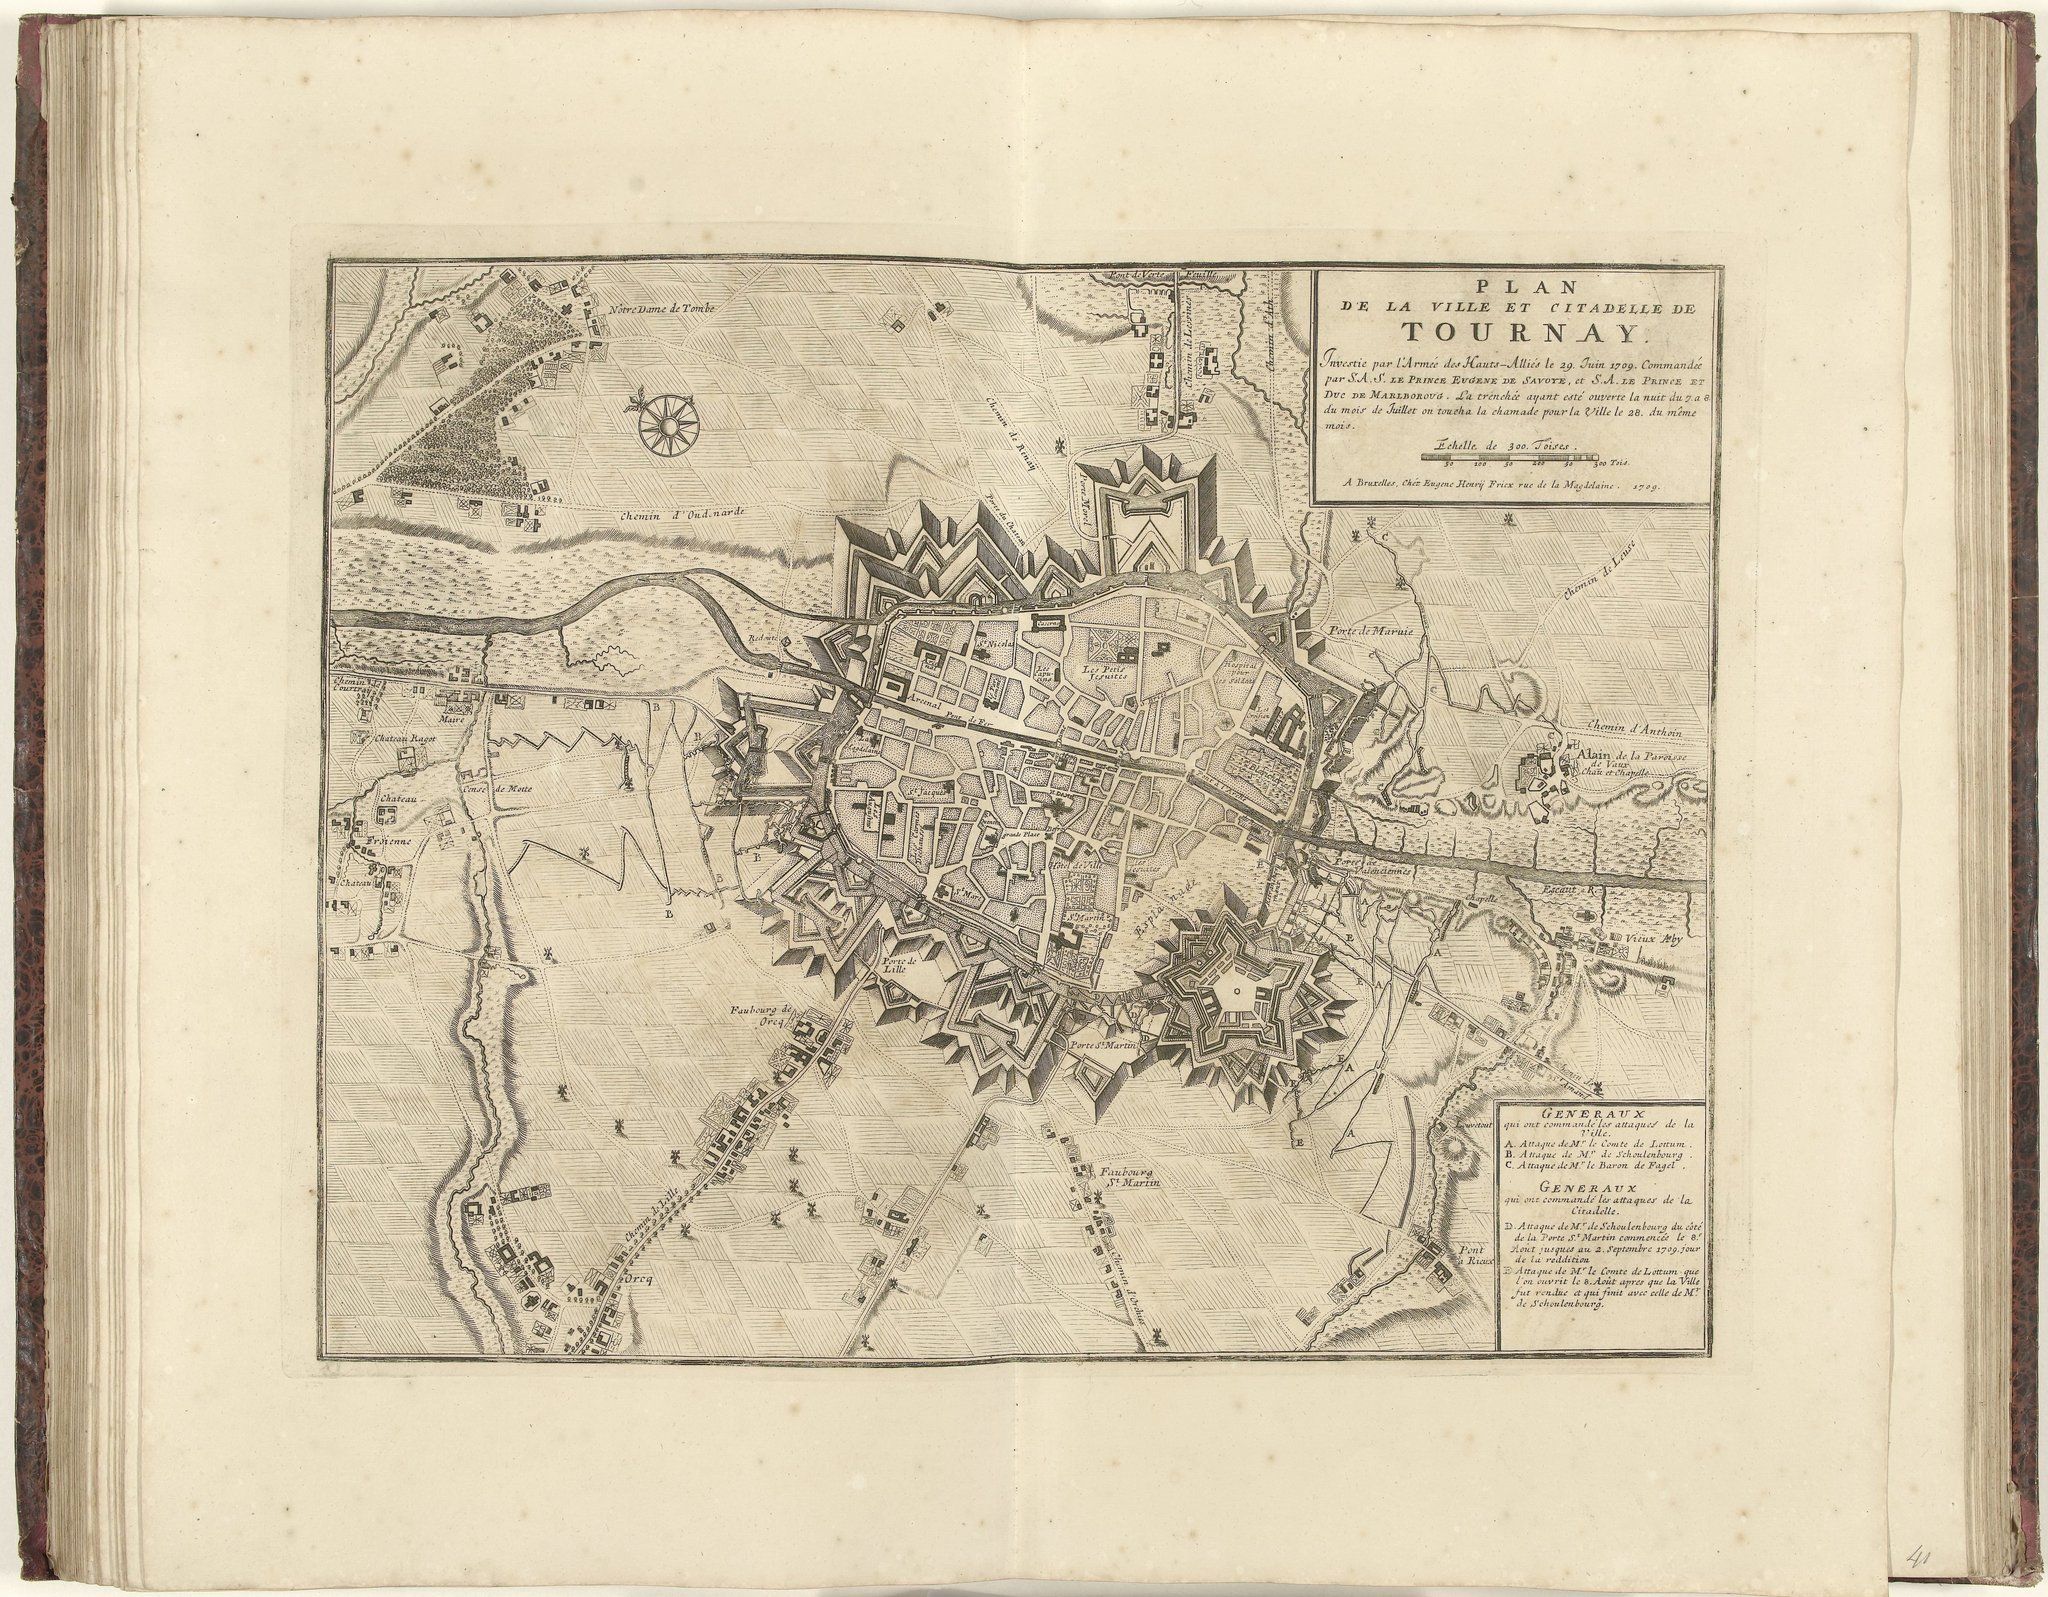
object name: print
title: Beleg van Tournai, 1709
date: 1709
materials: paper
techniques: engraving, etching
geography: brussels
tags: paris, vienna, eugenius van savoye, john churchill (1e hertog van marlborough), siege, position war, maps of cities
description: Kaart van het beleg van Tournai. De stad belegerd door de Geallieerden onder de hertog van Marlborough en de prins van Savoye vanaf 29 juni en ingenomen op 2 september 1709. Onderdeel van een gebundelde verzameling van plannen van veldslagen en steden vermaard in de Spaanse Successieoorlog.